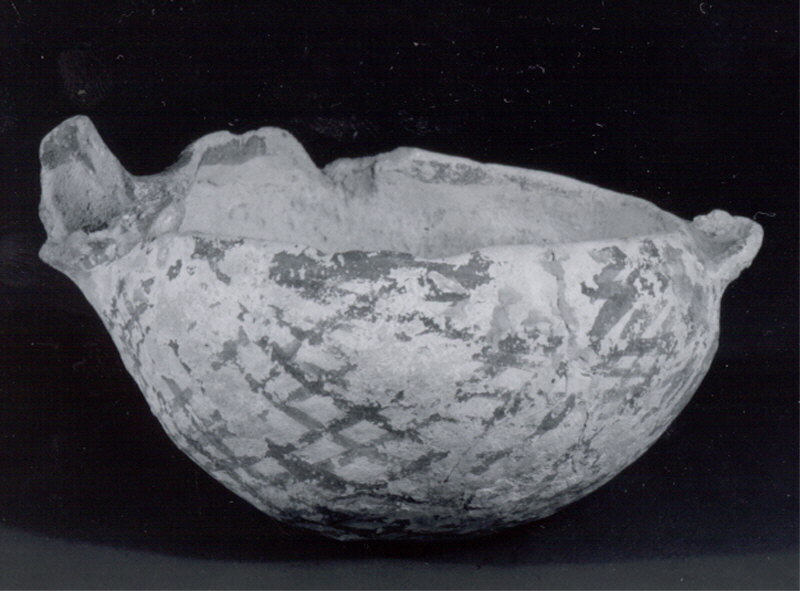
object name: vessel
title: Spouted vessel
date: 3000-2001 BCE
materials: ceramic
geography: levant